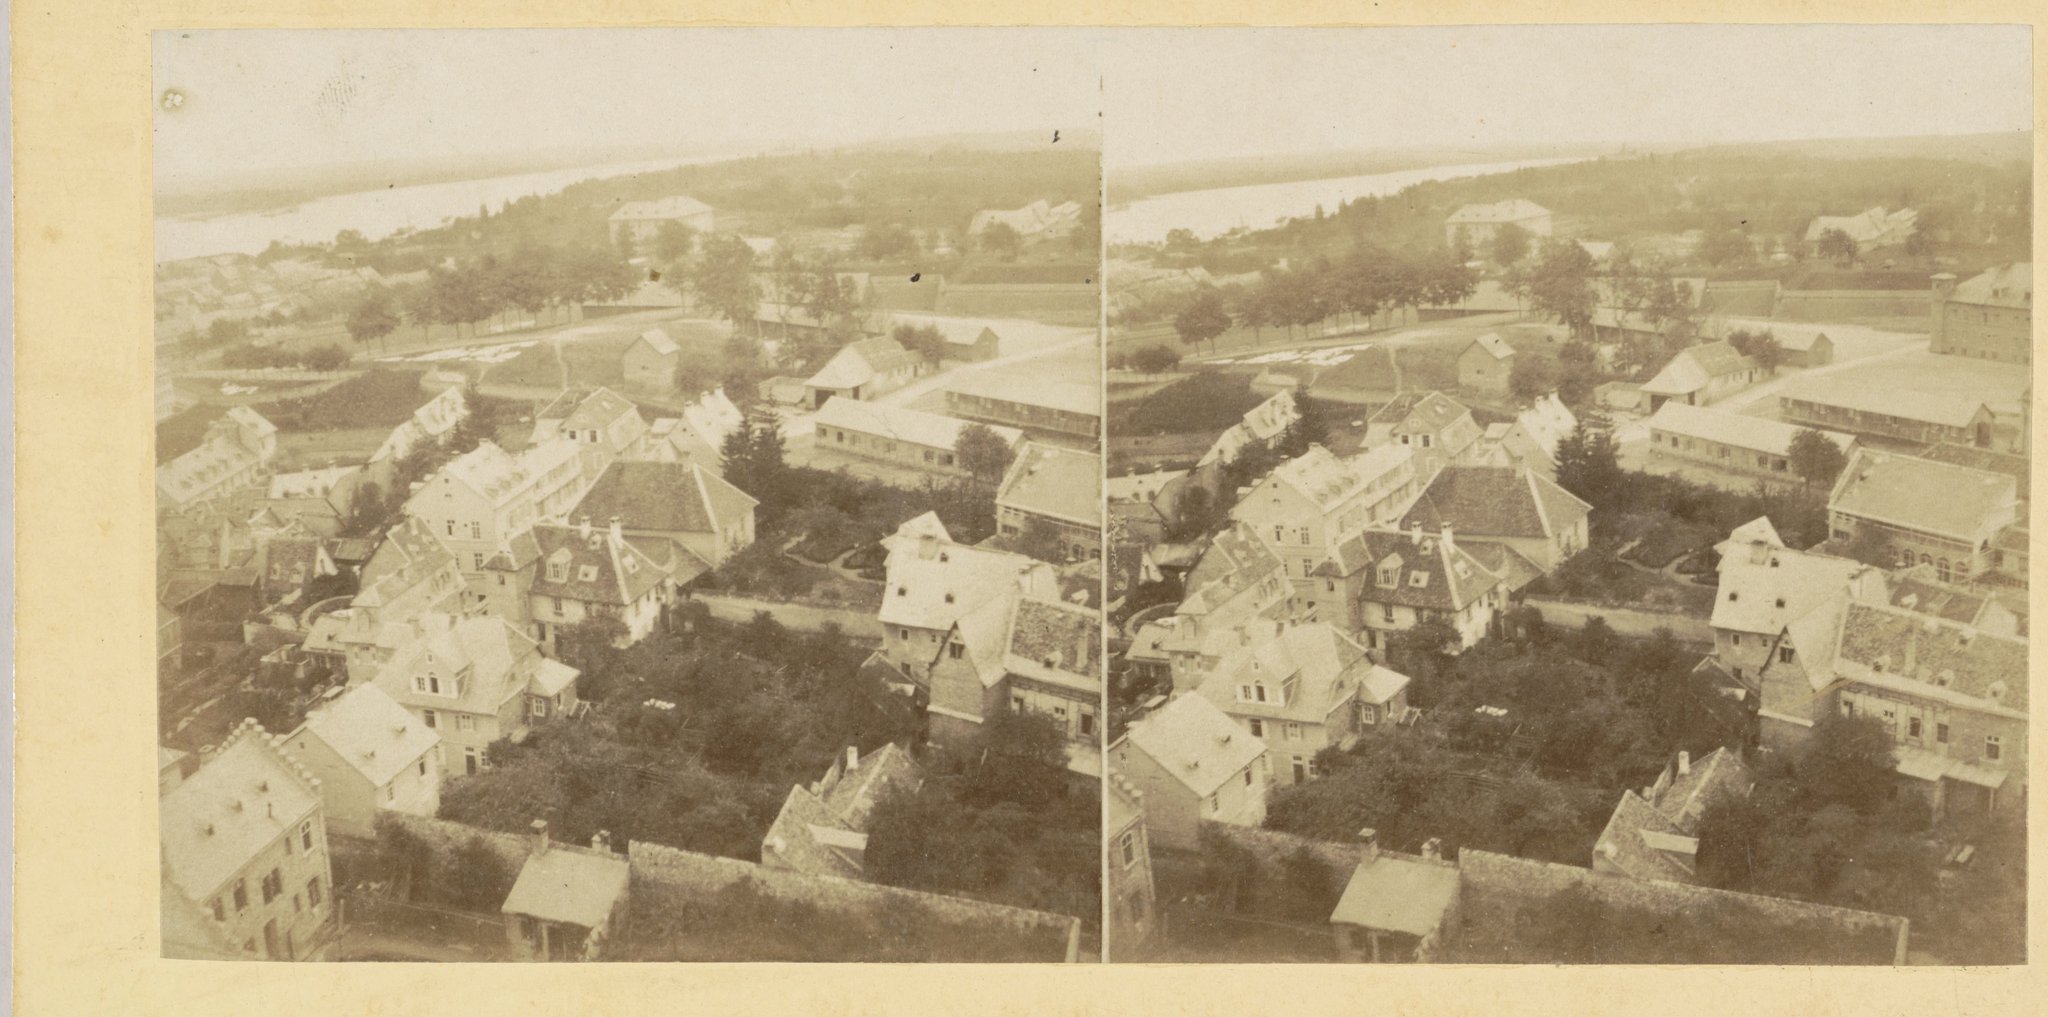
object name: stereograph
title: Panorama de Mayence, côté du Levant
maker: Anonymous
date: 1861-1870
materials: cardboard, paper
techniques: albumen print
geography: mainz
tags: city-view in general; 'veduta'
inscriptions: inscription: ‘J. CONTAL/ Rue Saint Dizier 356 à Nancy’, number: ‘No 64’, inscription: ‘M/ L’